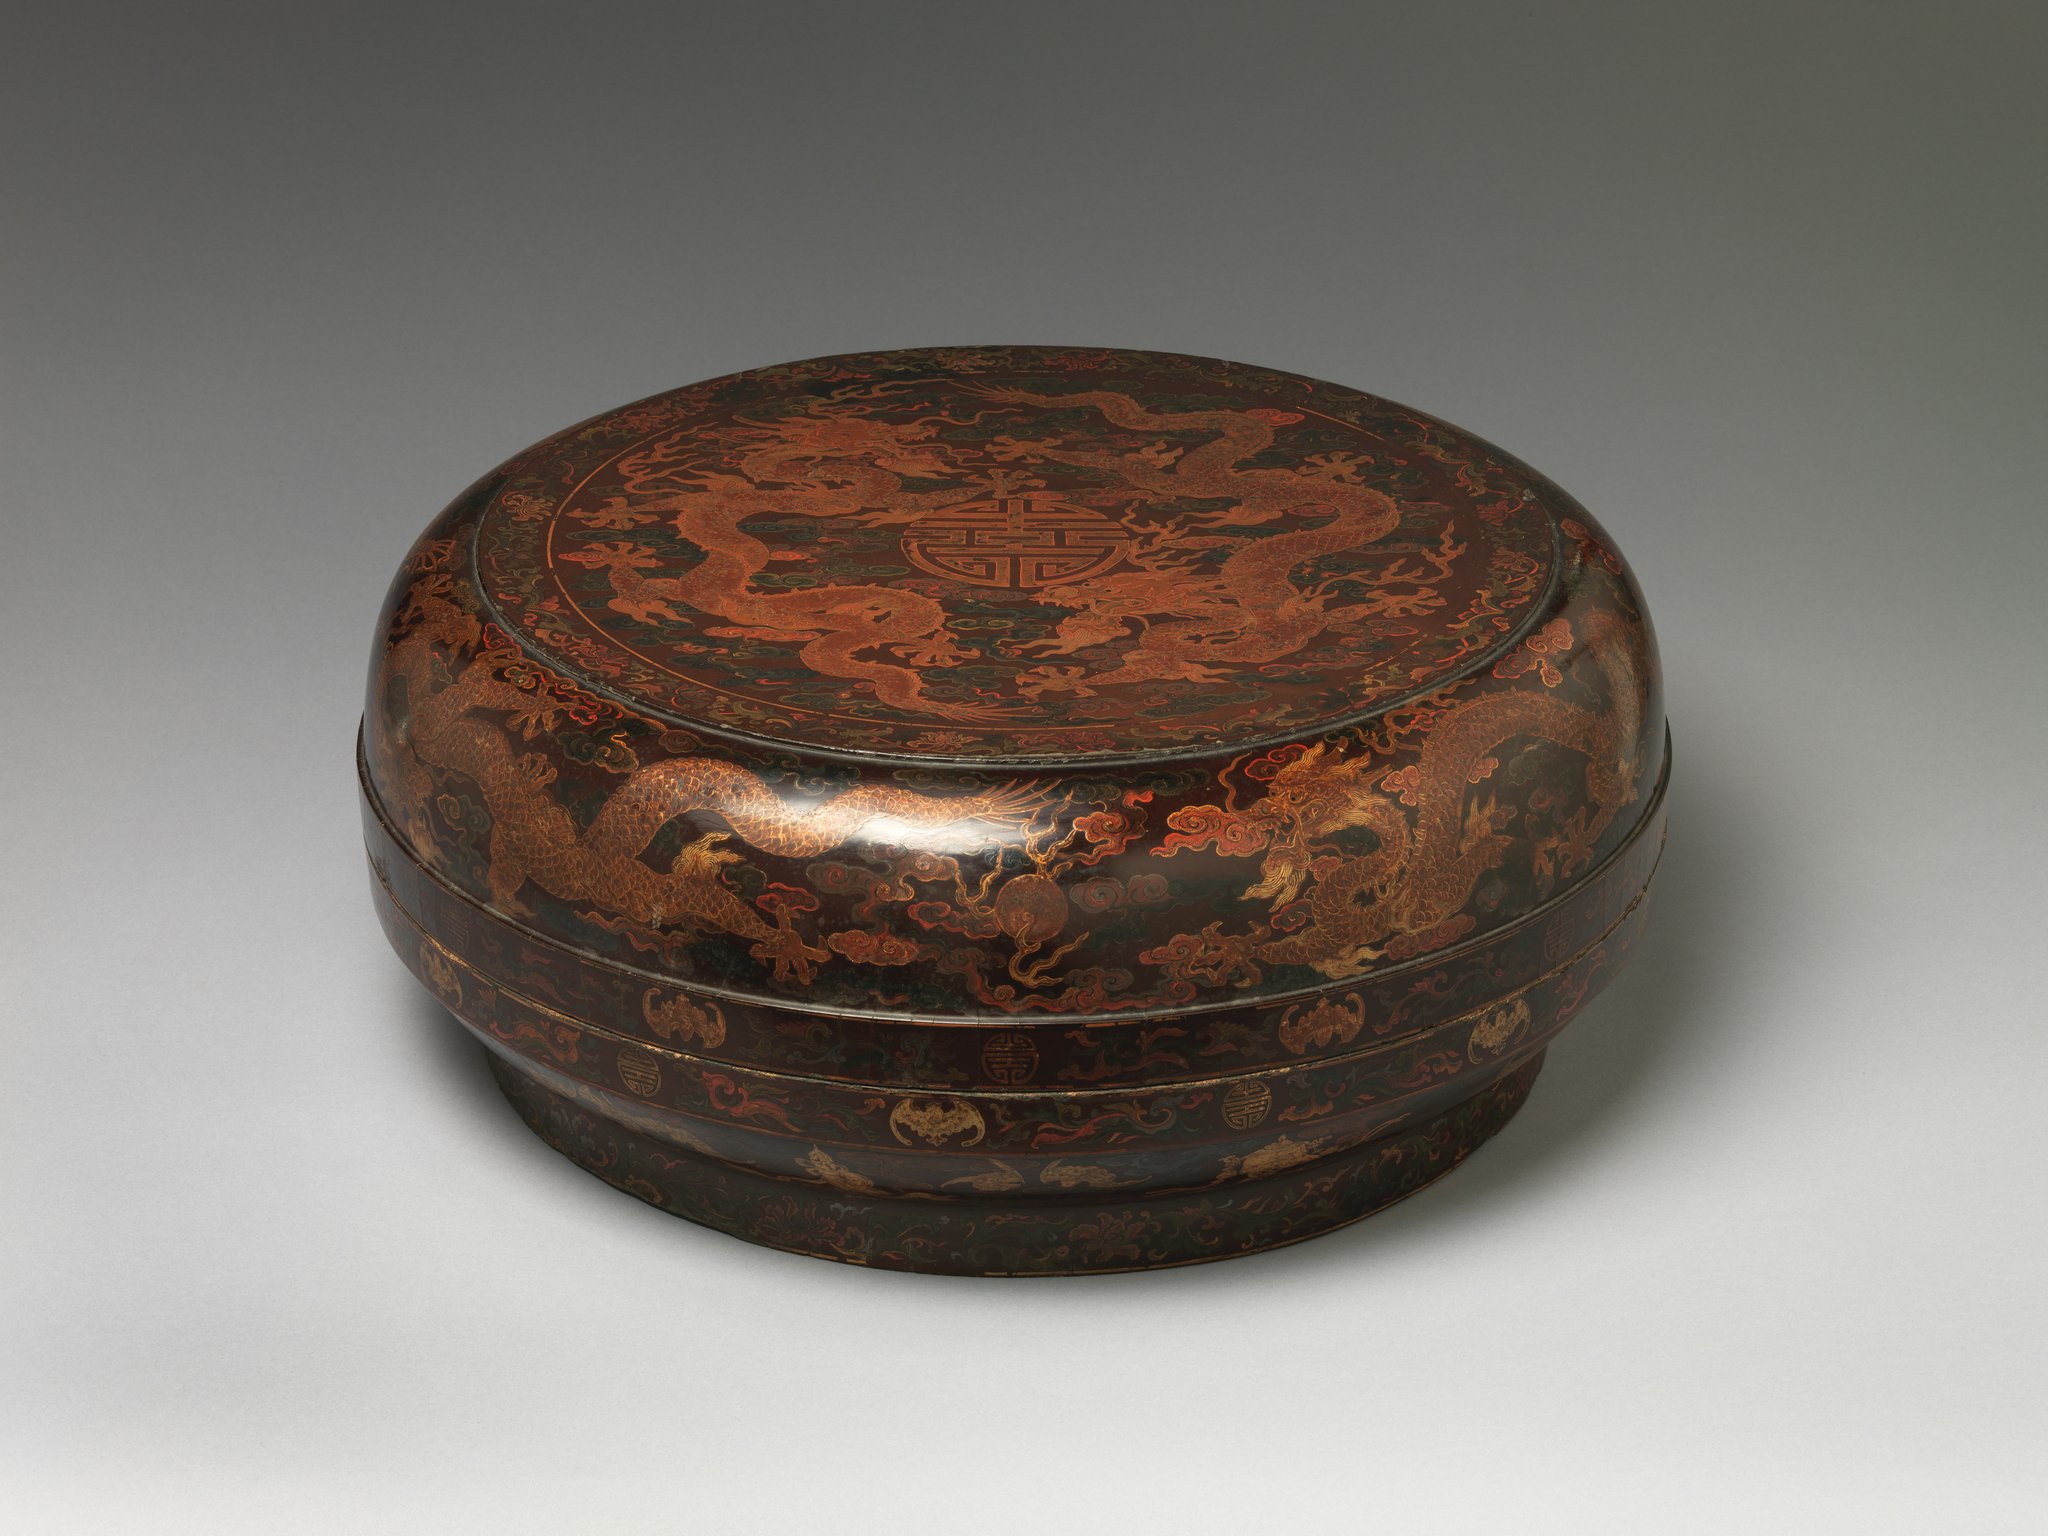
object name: box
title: Circular Food Box with Dragons and the Character Shou (Longevity)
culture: chinese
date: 1701-1900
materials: gold, lacquer, oil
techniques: painting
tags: dragons